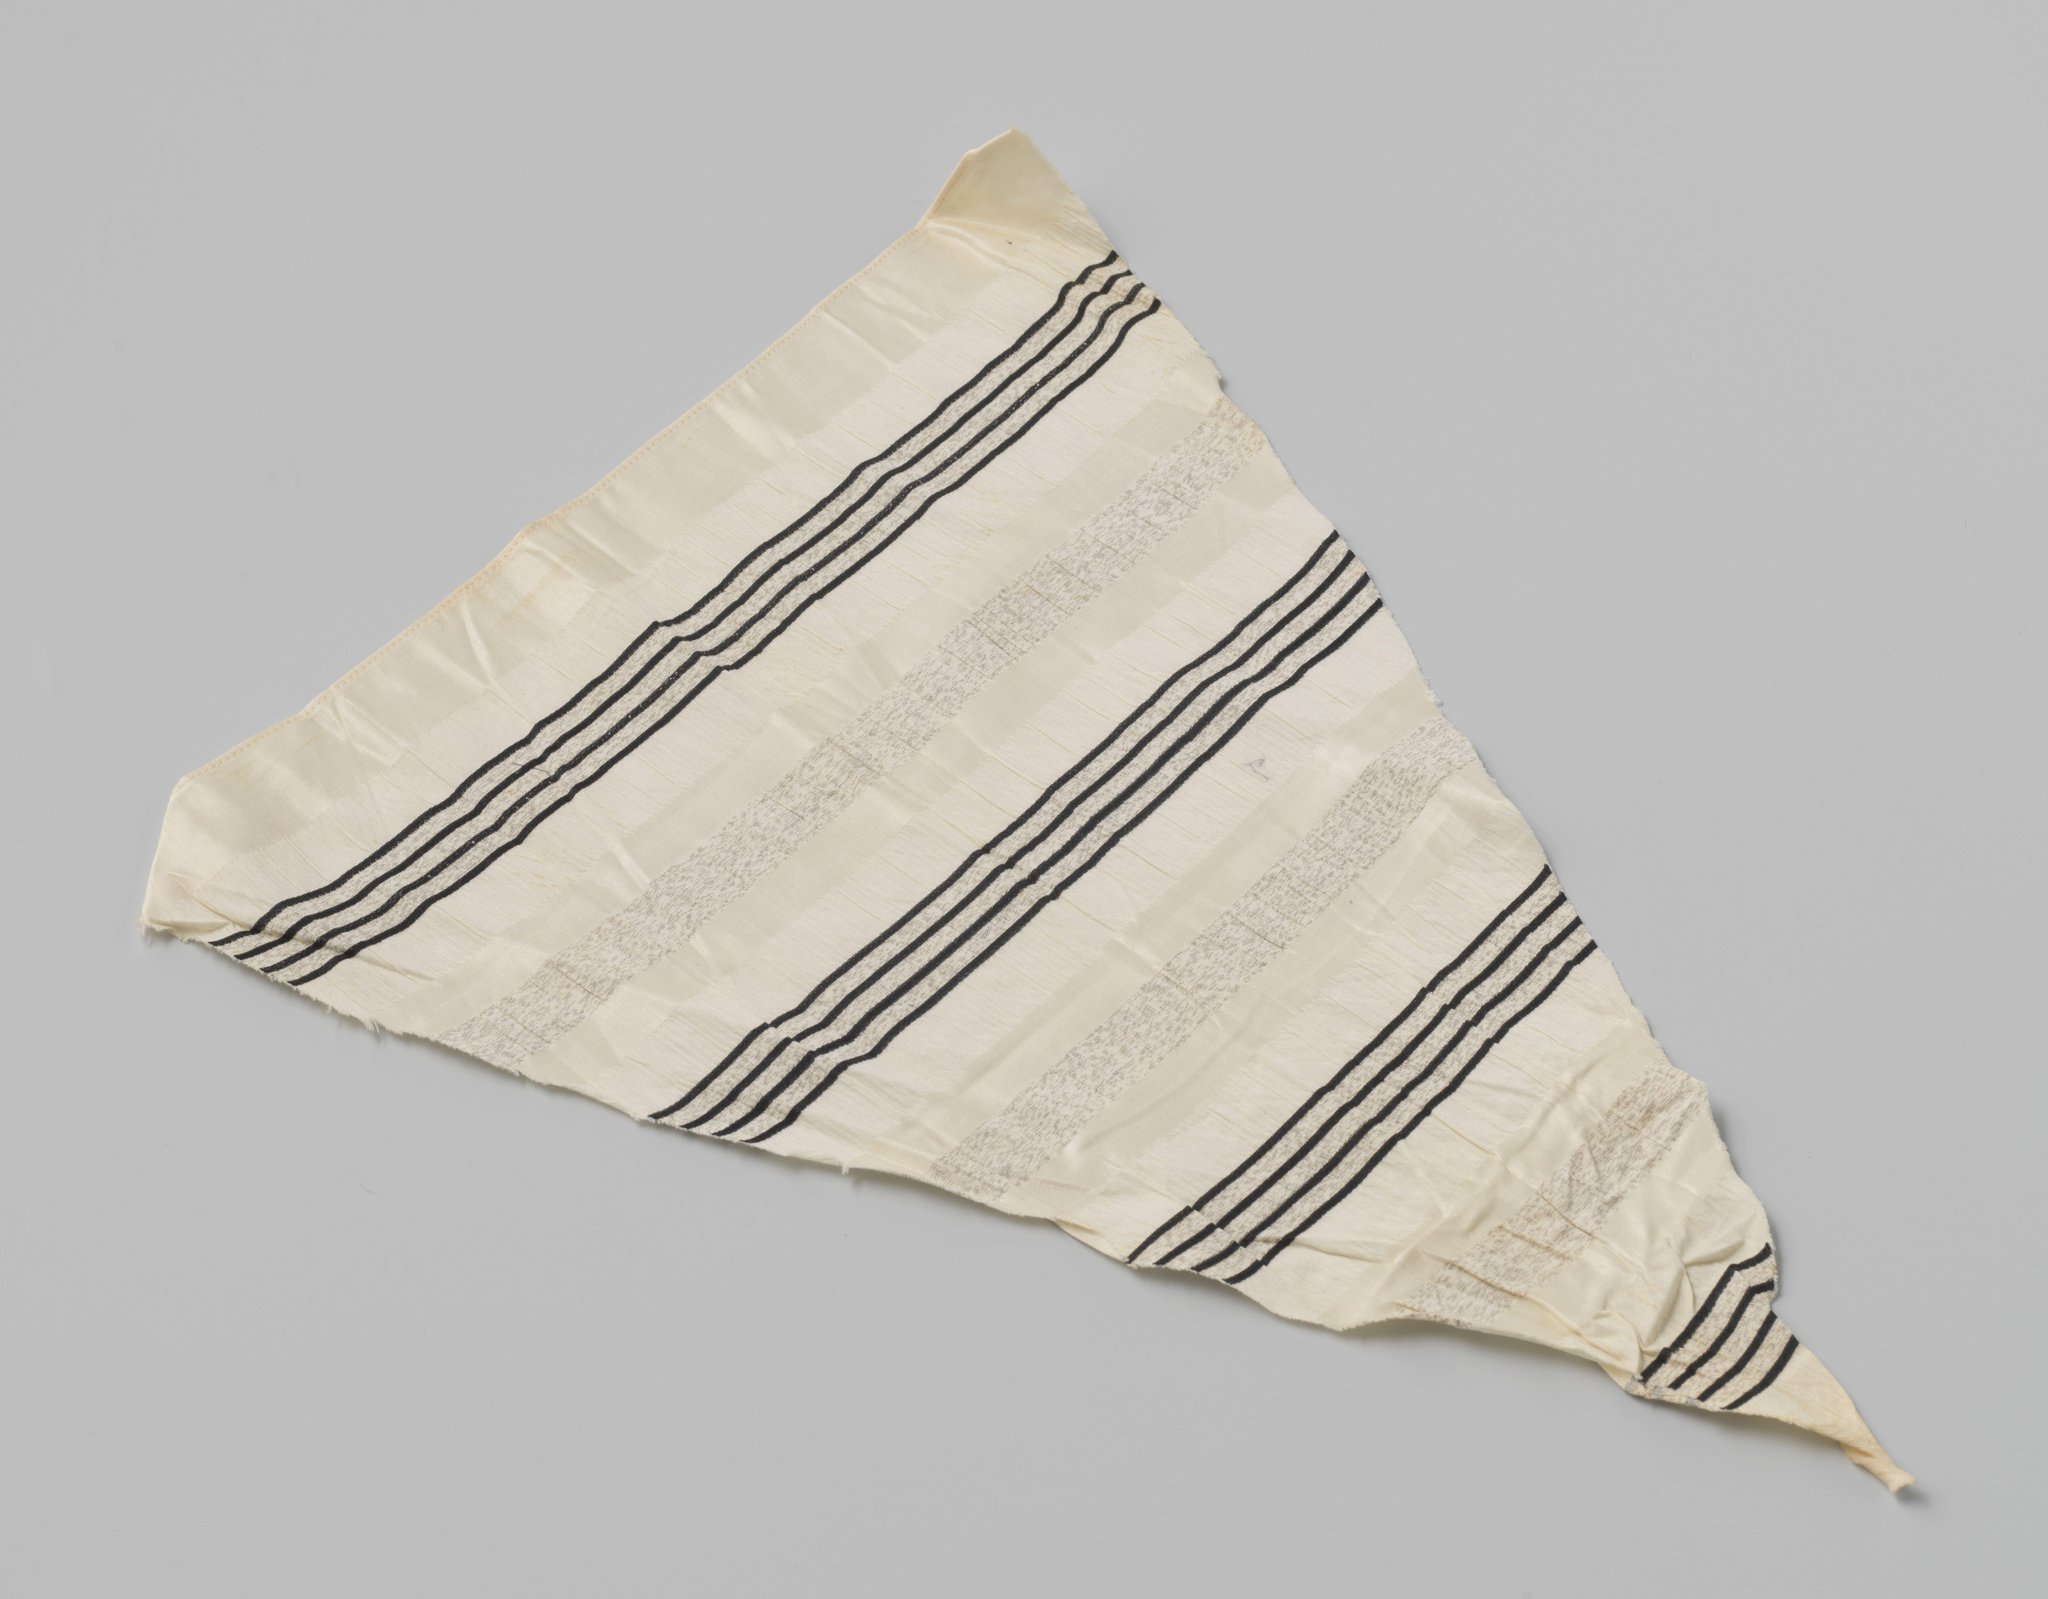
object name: fragment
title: Parasolsector van wit katoen met crêpe strepen en gladde satijnen strepen in verschillende kleuren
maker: gustav schnitzler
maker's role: paraplufabrikant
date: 1910-1940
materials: cotton, textile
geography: nijmegen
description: Metrage parasolkatoen; stukgoed. In wit met crêpe strepen en gladde grijze, zwarte en wit satijnen strepen. Eén parasolsector van deze katoen.